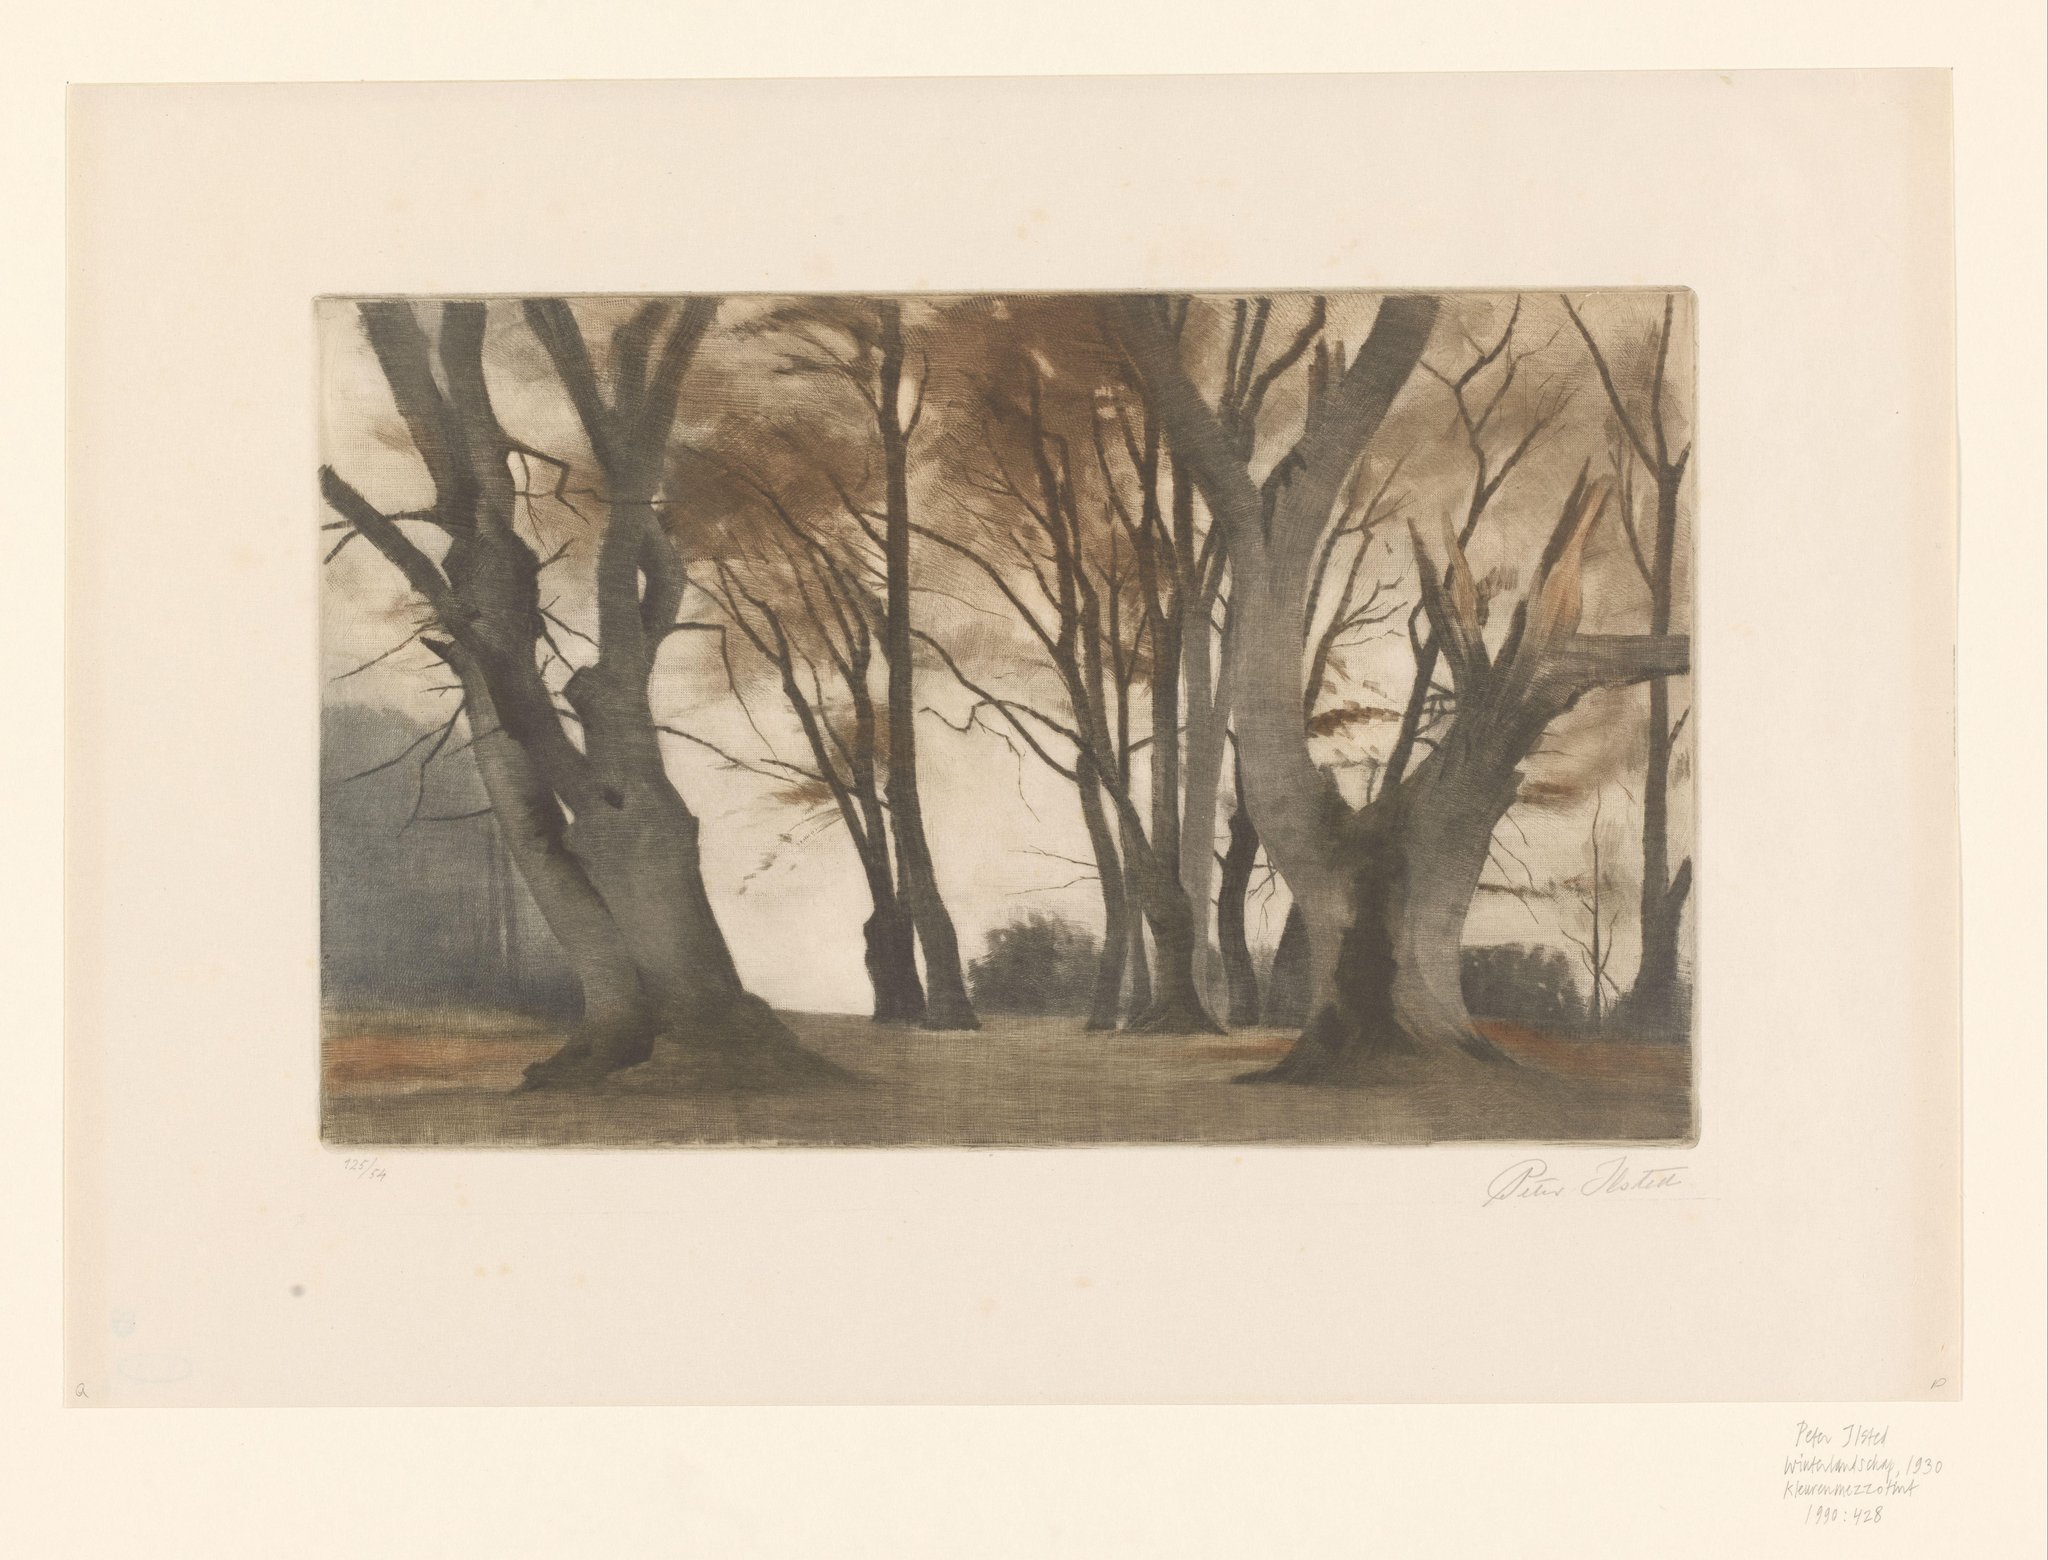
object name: print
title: Landschap met kale bomen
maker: peter vilhelm ilsted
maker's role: print maker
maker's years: 1861-1933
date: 1930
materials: paper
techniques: roulette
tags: trees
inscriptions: collector's mark: Lugt 2228, collector's mark: Lugt 2760